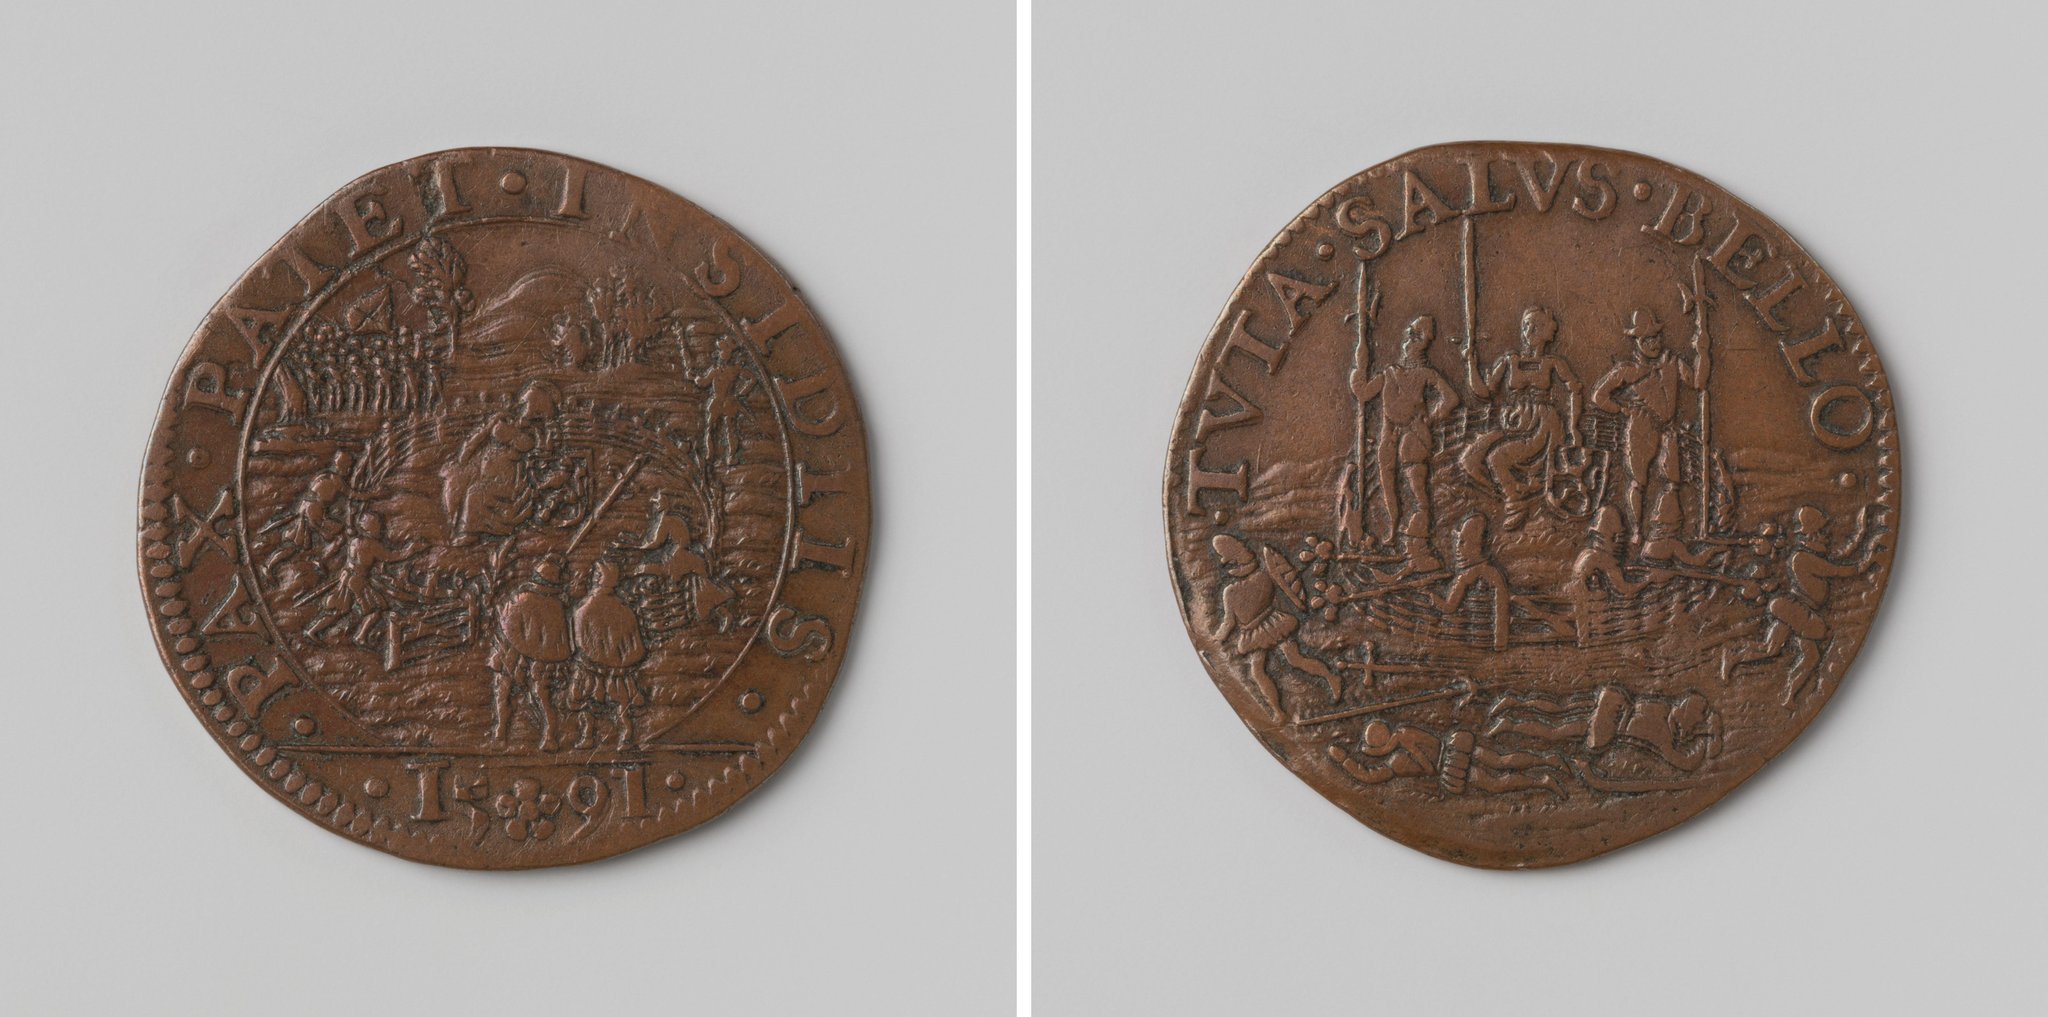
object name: jeton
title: Waarschuwing tegen de vredesvoorstellen van Rudolf II, Duits keizer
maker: Anonymous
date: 1591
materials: copper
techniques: striking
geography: dordrecht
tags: vienna, prague, rudolf ii van habsburg (duits keizer)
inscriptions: circumscription: ‘TVTA SALVS BELLO’, circumscription: ‘PAX PATET INSIDIIS / 1591’